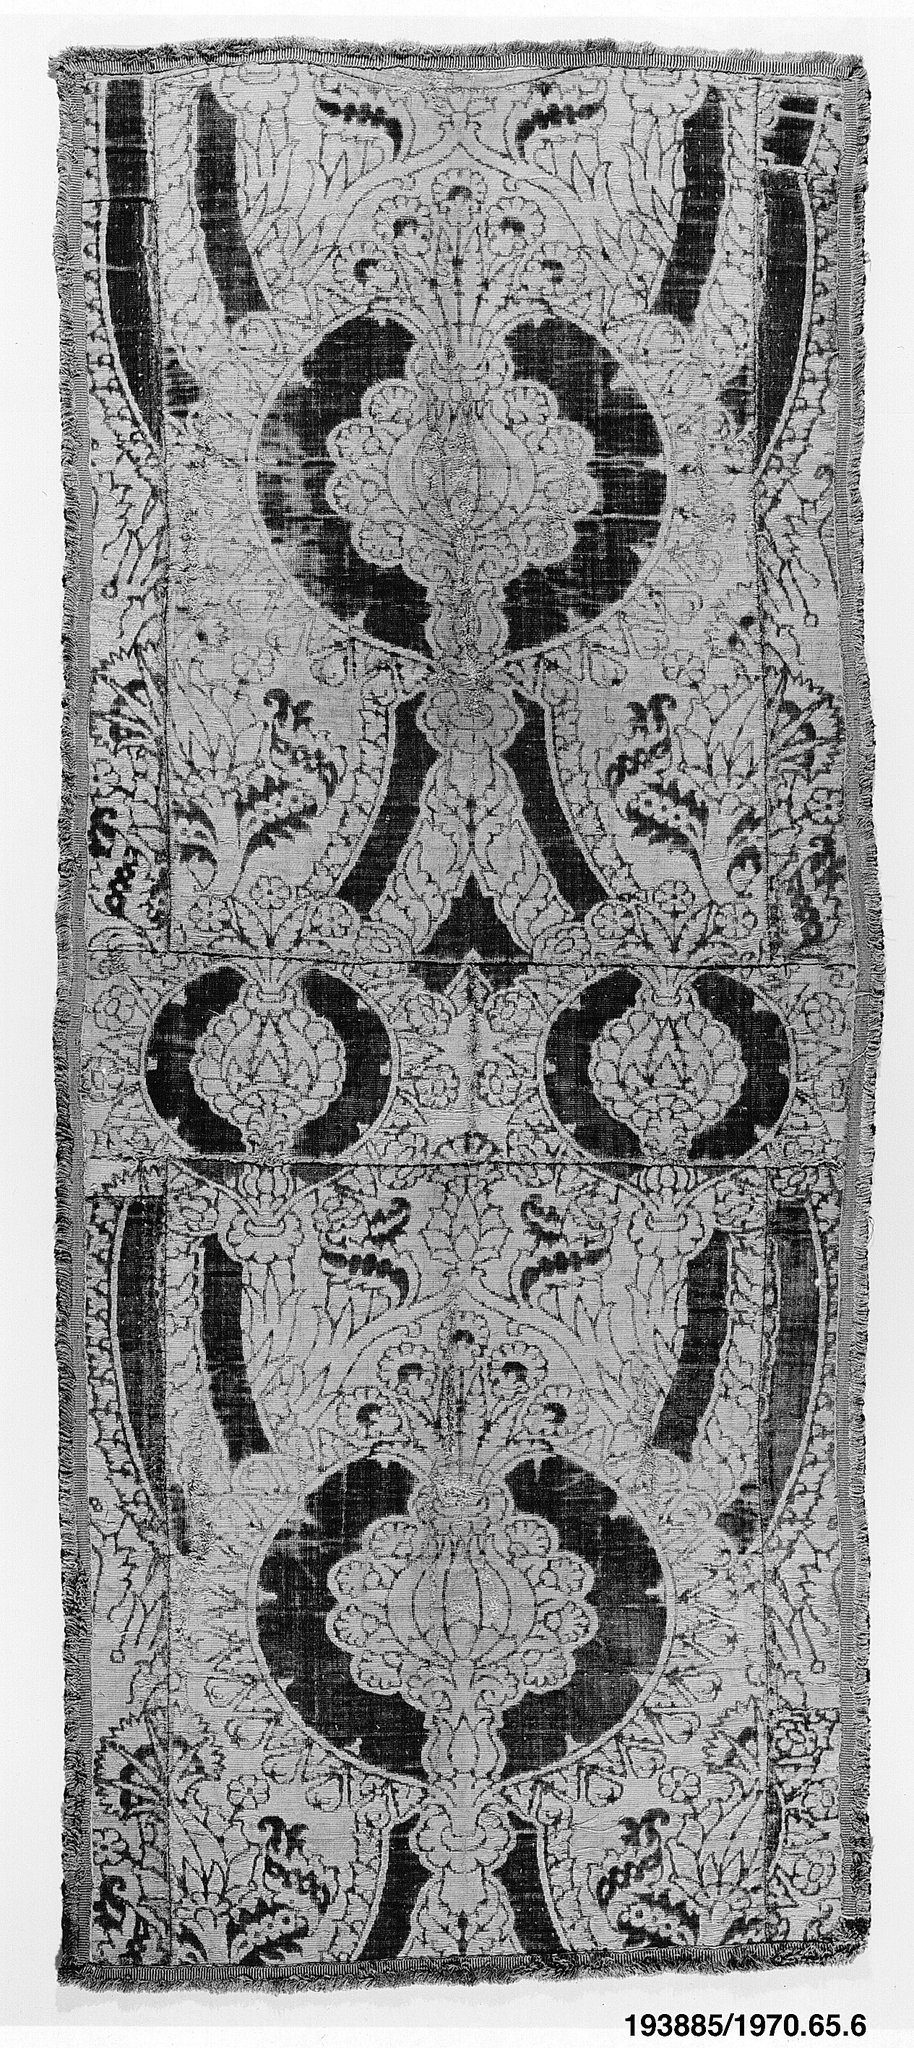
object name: fragment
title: Length of velvet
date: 1401-1600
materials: metal thread, silk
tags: flowers